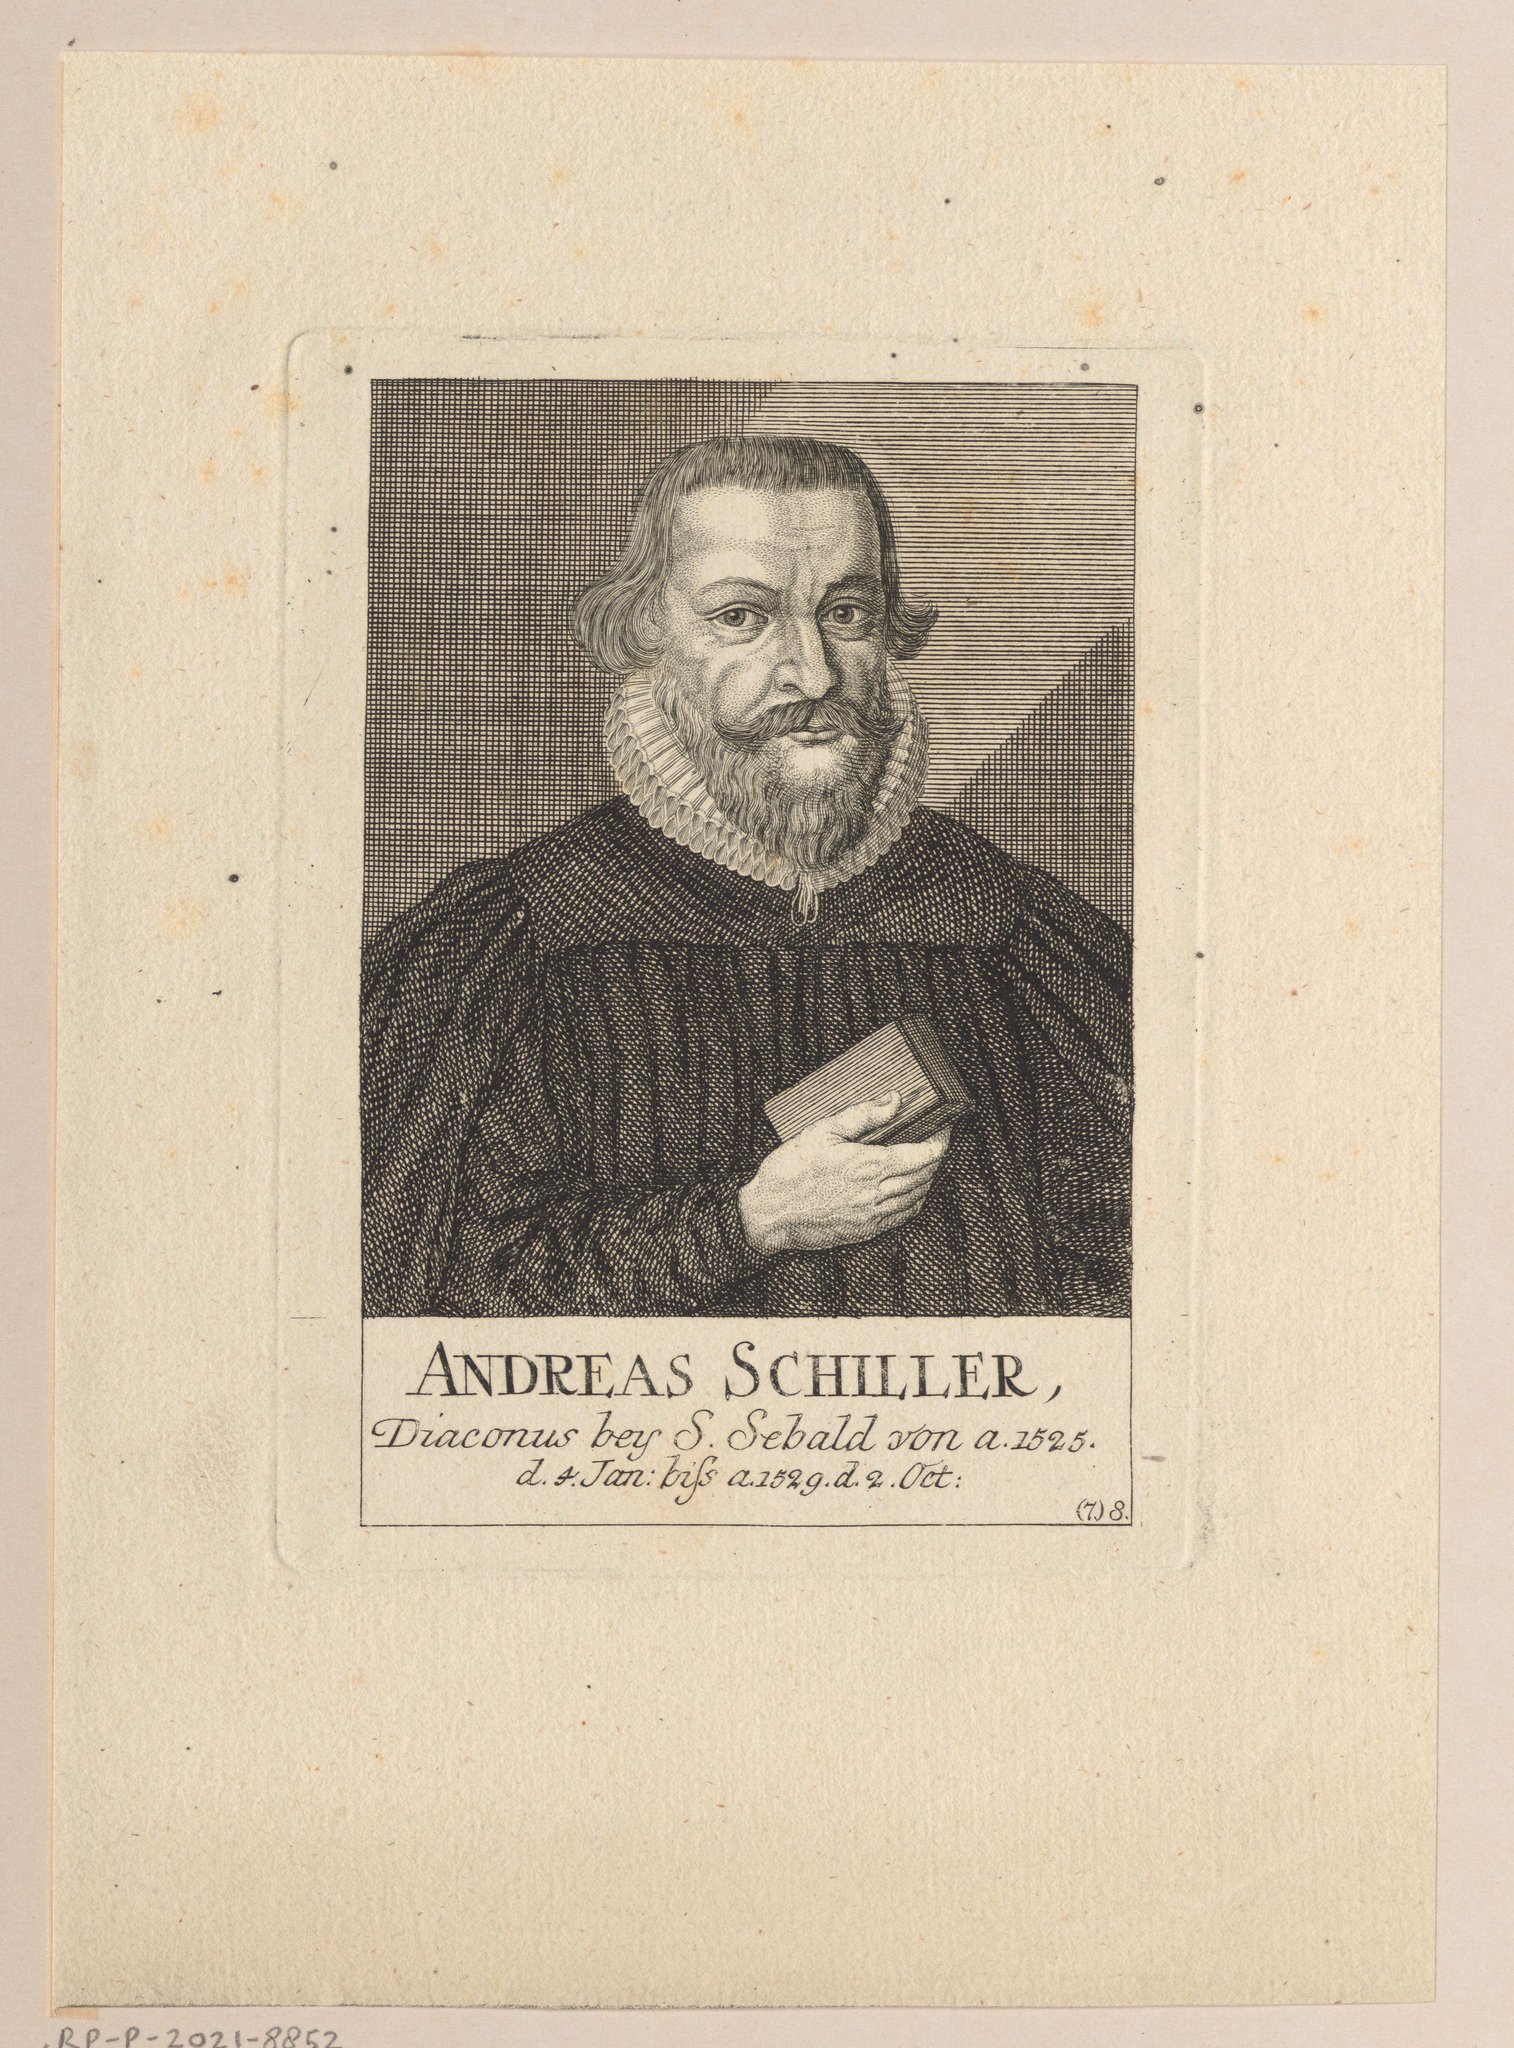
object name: print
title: Portret van Andreas Schiller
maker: christoph melchior roth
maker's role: print maker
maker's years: 1720-1798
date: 1756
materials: paper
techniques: engraving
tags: theologian, historical persons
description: Prent waarschijnlijk uit: Würfel, Andreas. Diptycha ecclesiae Sebaldianae (...). Neurenberg: Christoph Melchior Roth, 1756.